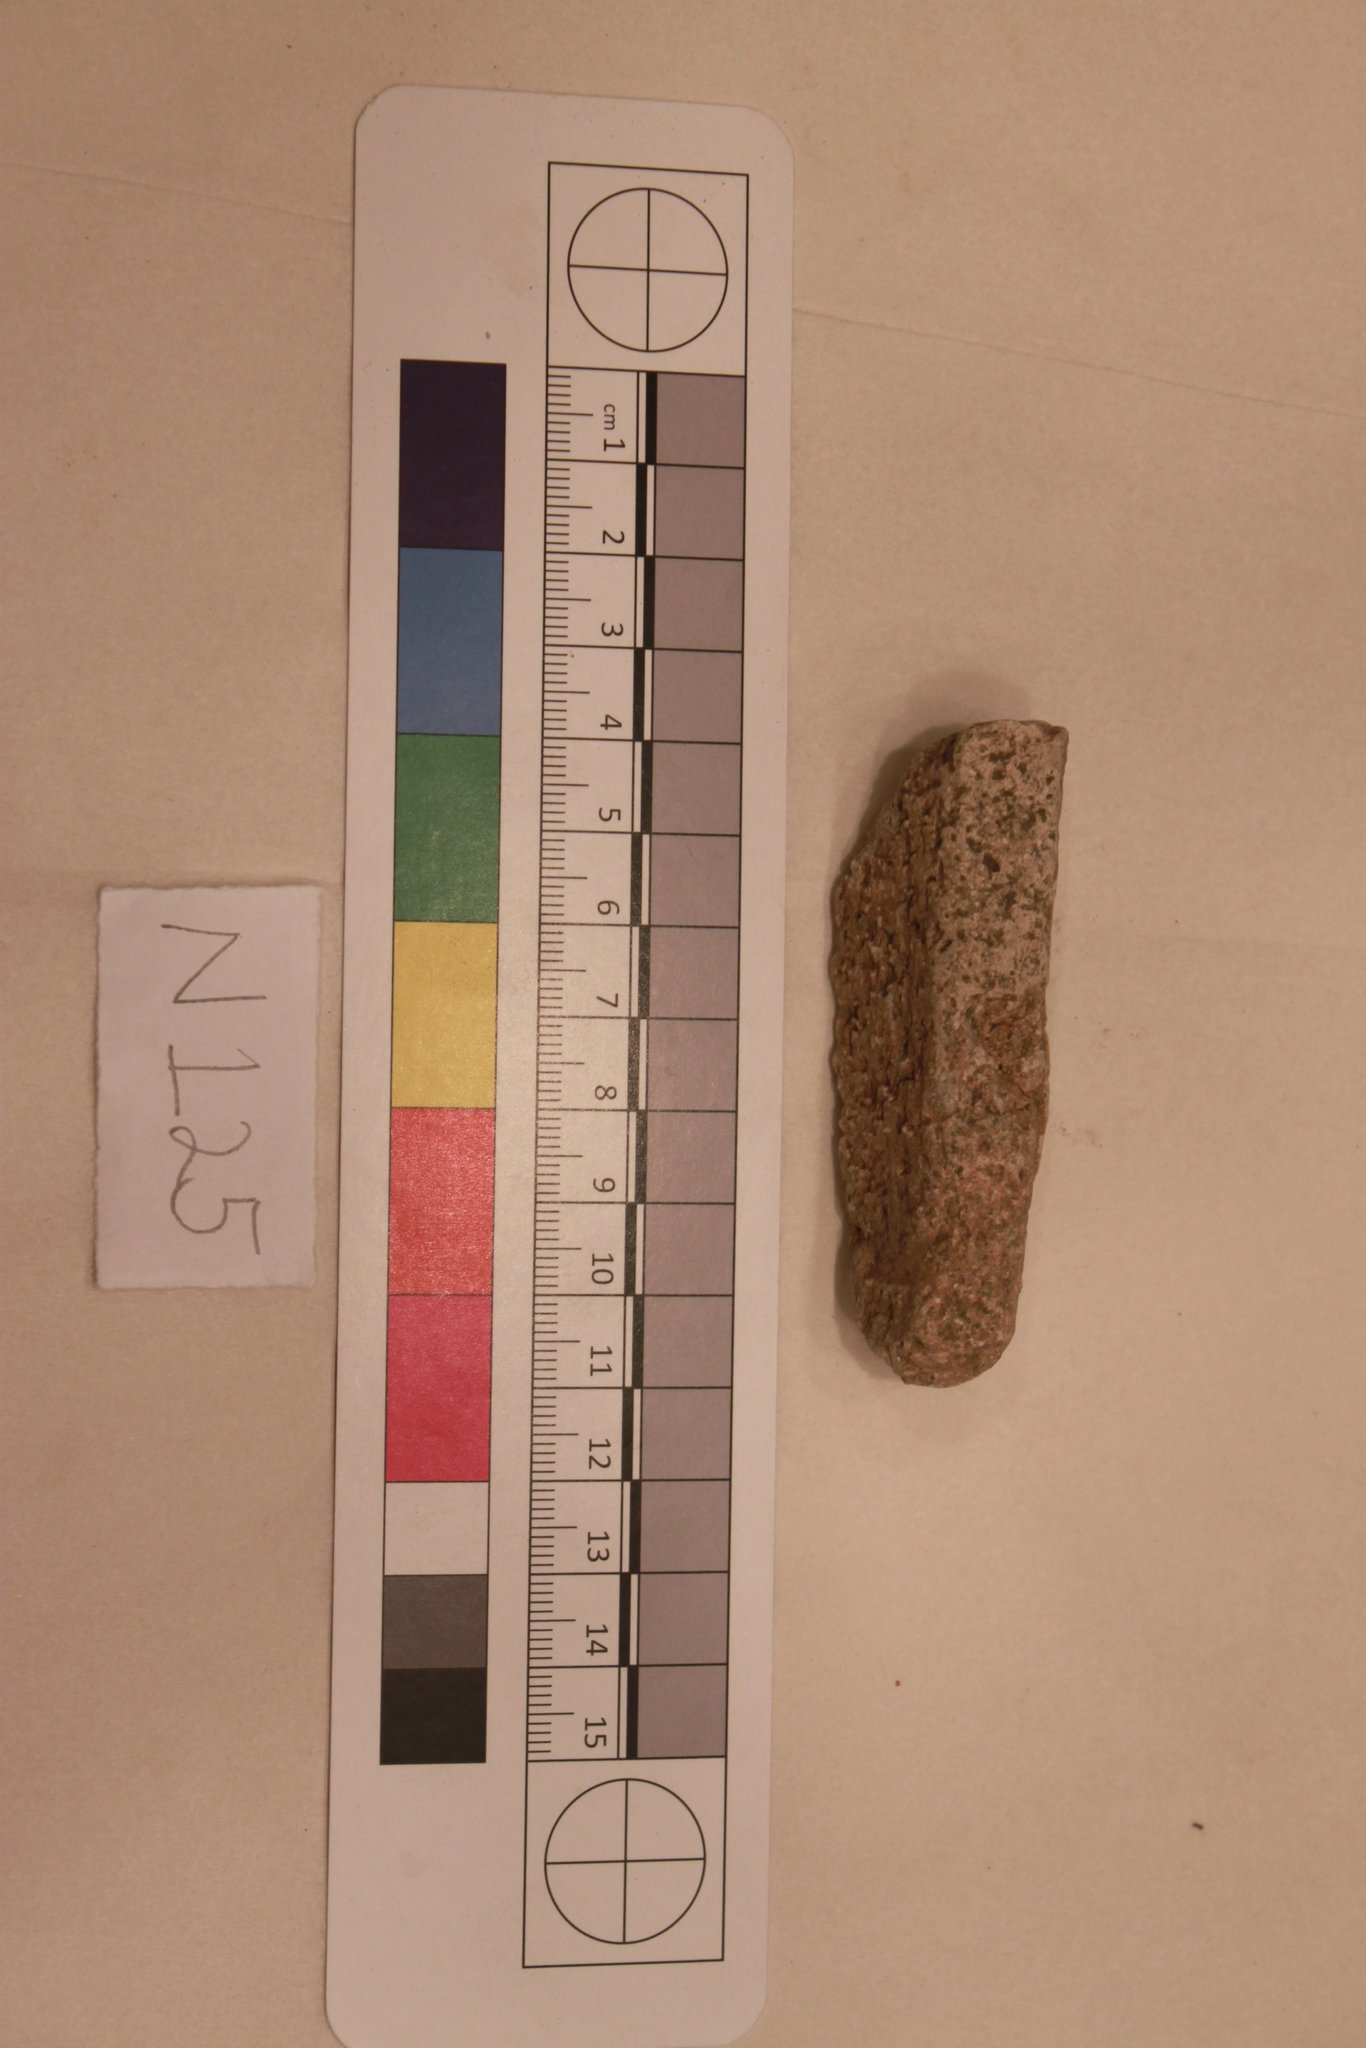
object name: fragment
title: Stucco Fragment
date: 701-1200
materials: plaster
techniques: carving, painting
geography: iran